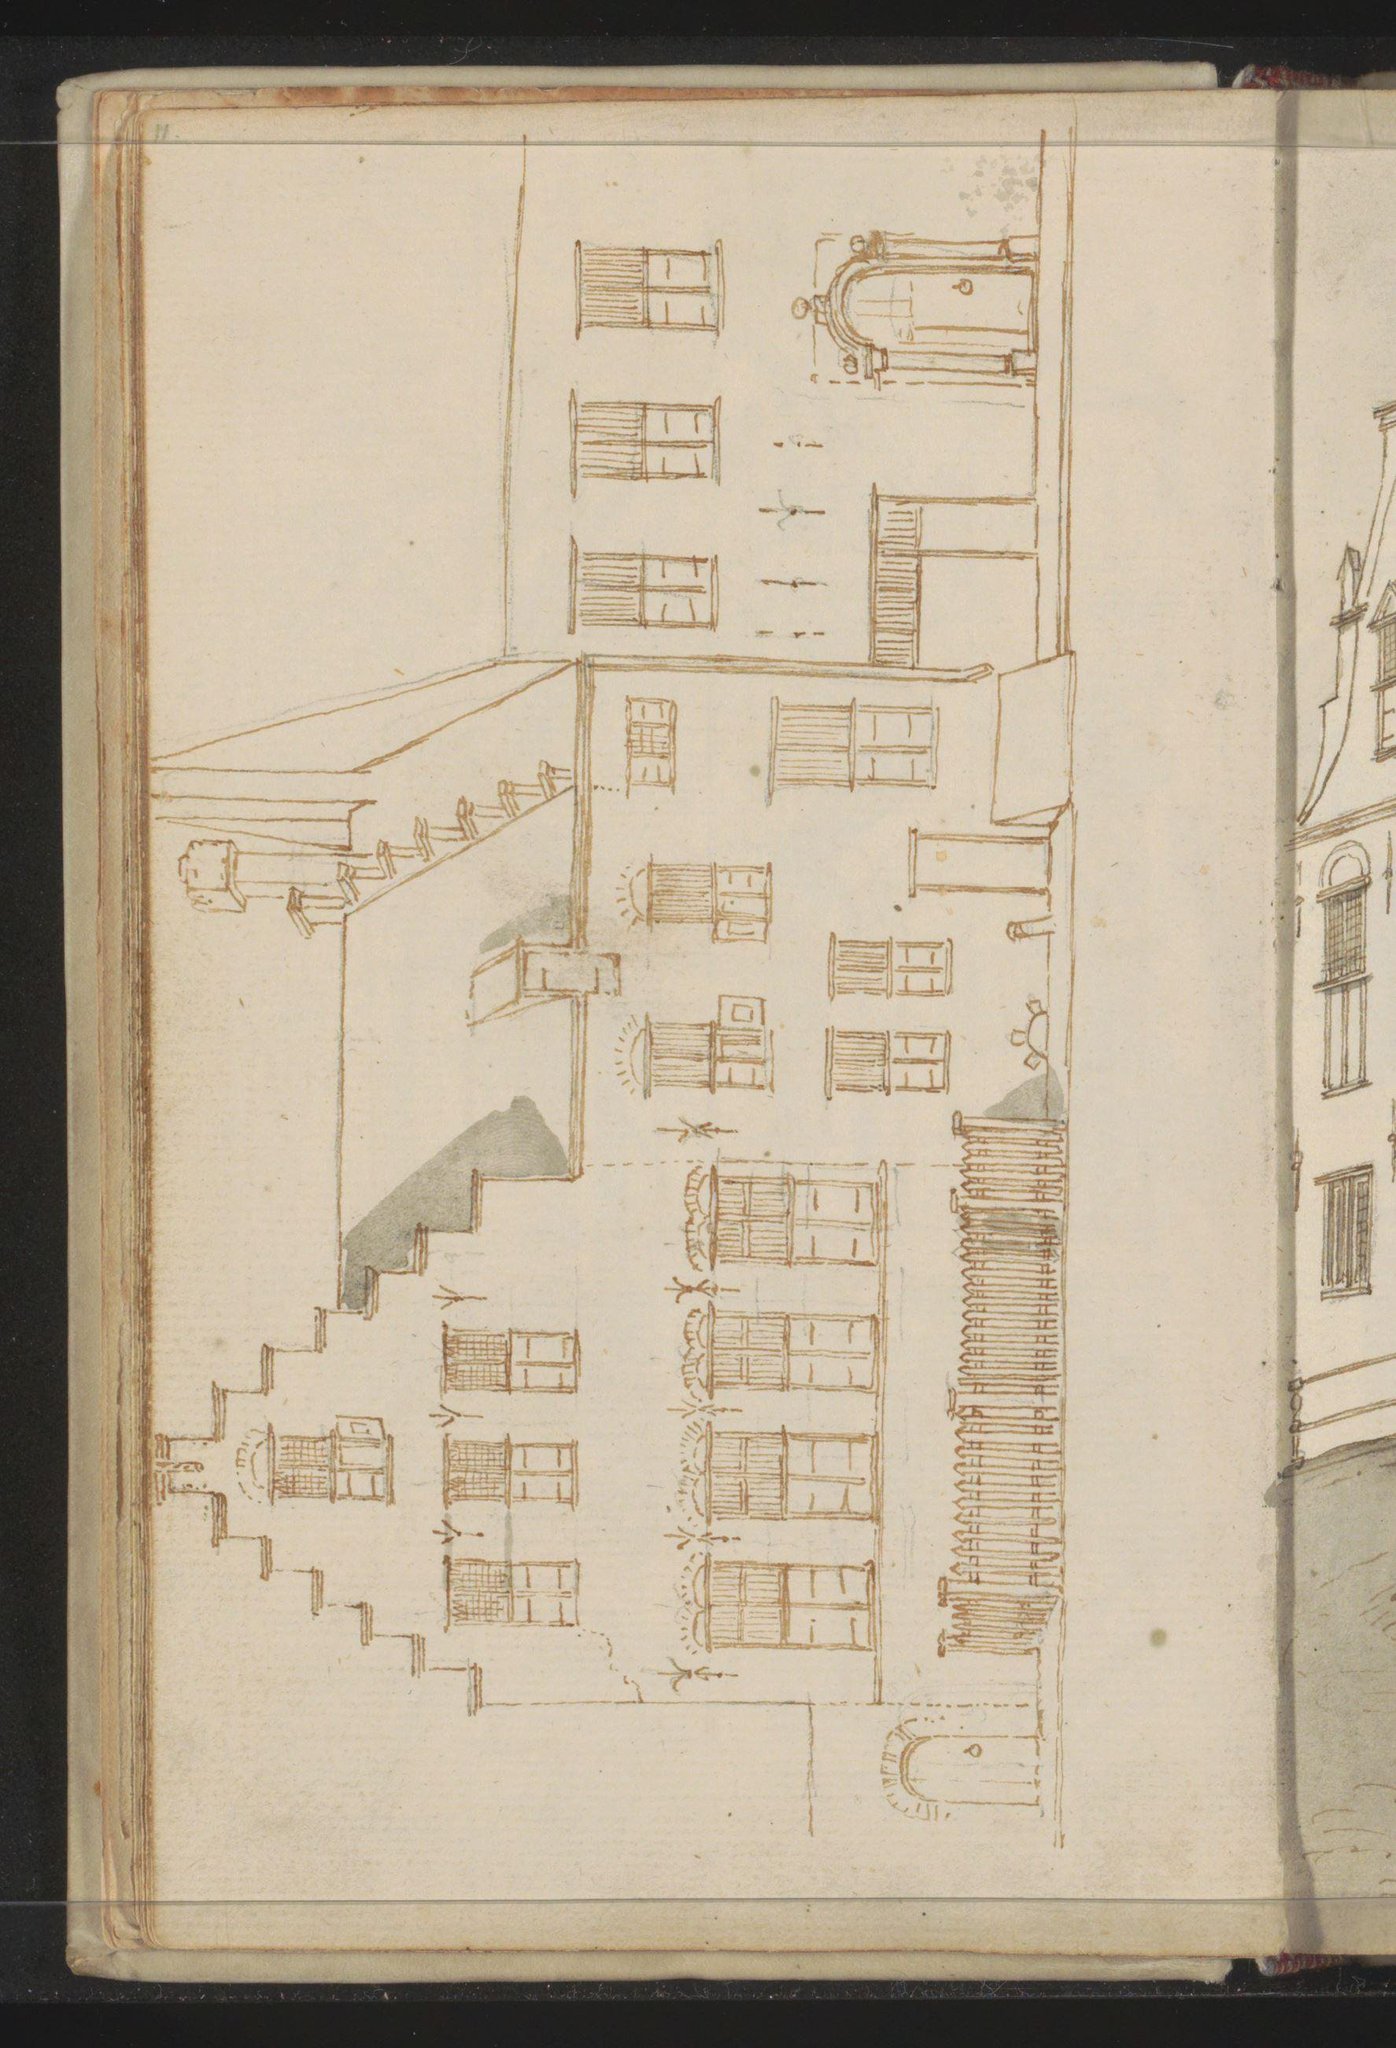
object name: sketchbook leaf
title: Huis met een trapgevel in een straat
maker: johannes huibert prins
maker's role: draughtsman, painter, print maker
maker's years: 1757-1806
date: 1783-1797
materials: ink, paper, pencil, watercolor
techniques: brush, pen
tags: decorated gable, façade (of house or building), street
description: Pagina 11 uit een schetsboek met 175 pagina's.